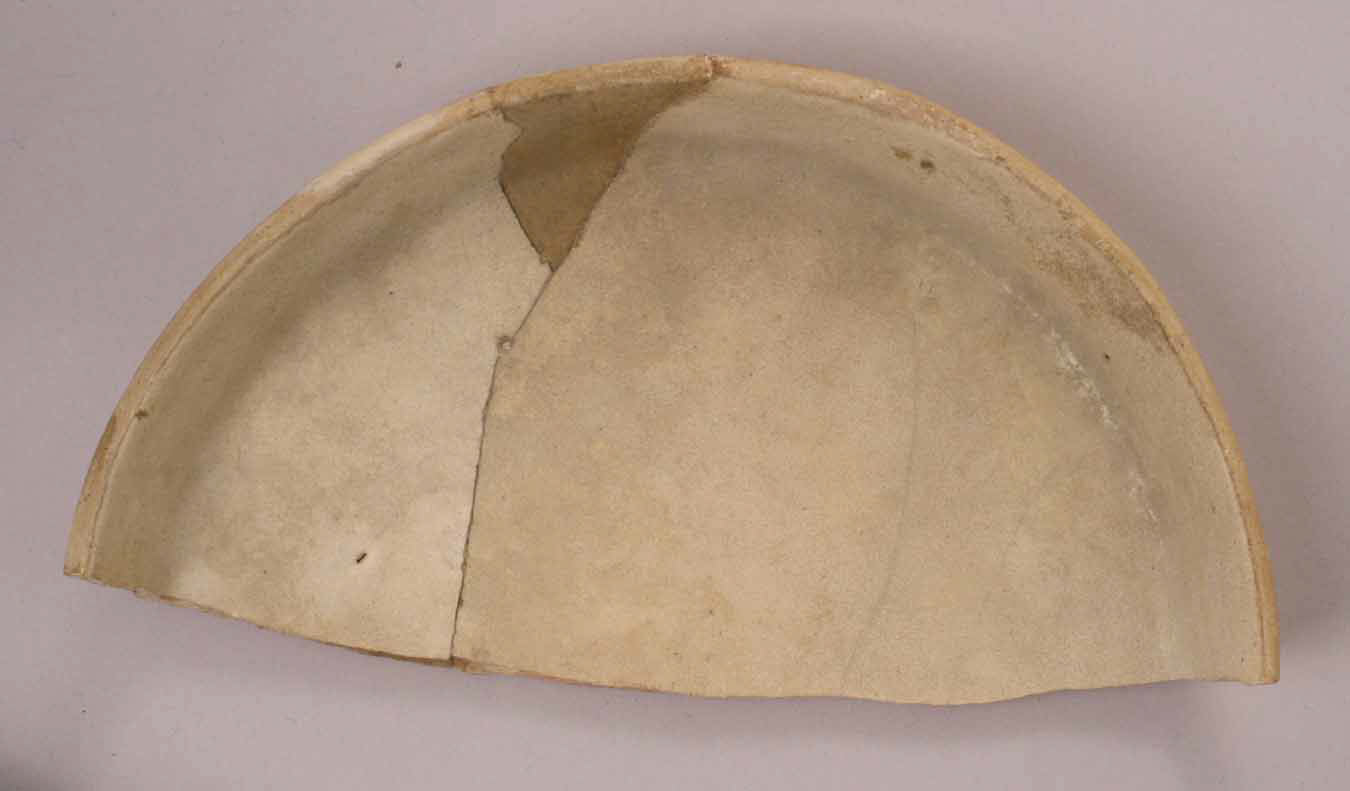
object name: fragment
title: Fragment of a Dish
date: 701-1000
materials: earthenware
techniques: glazing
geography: iraq